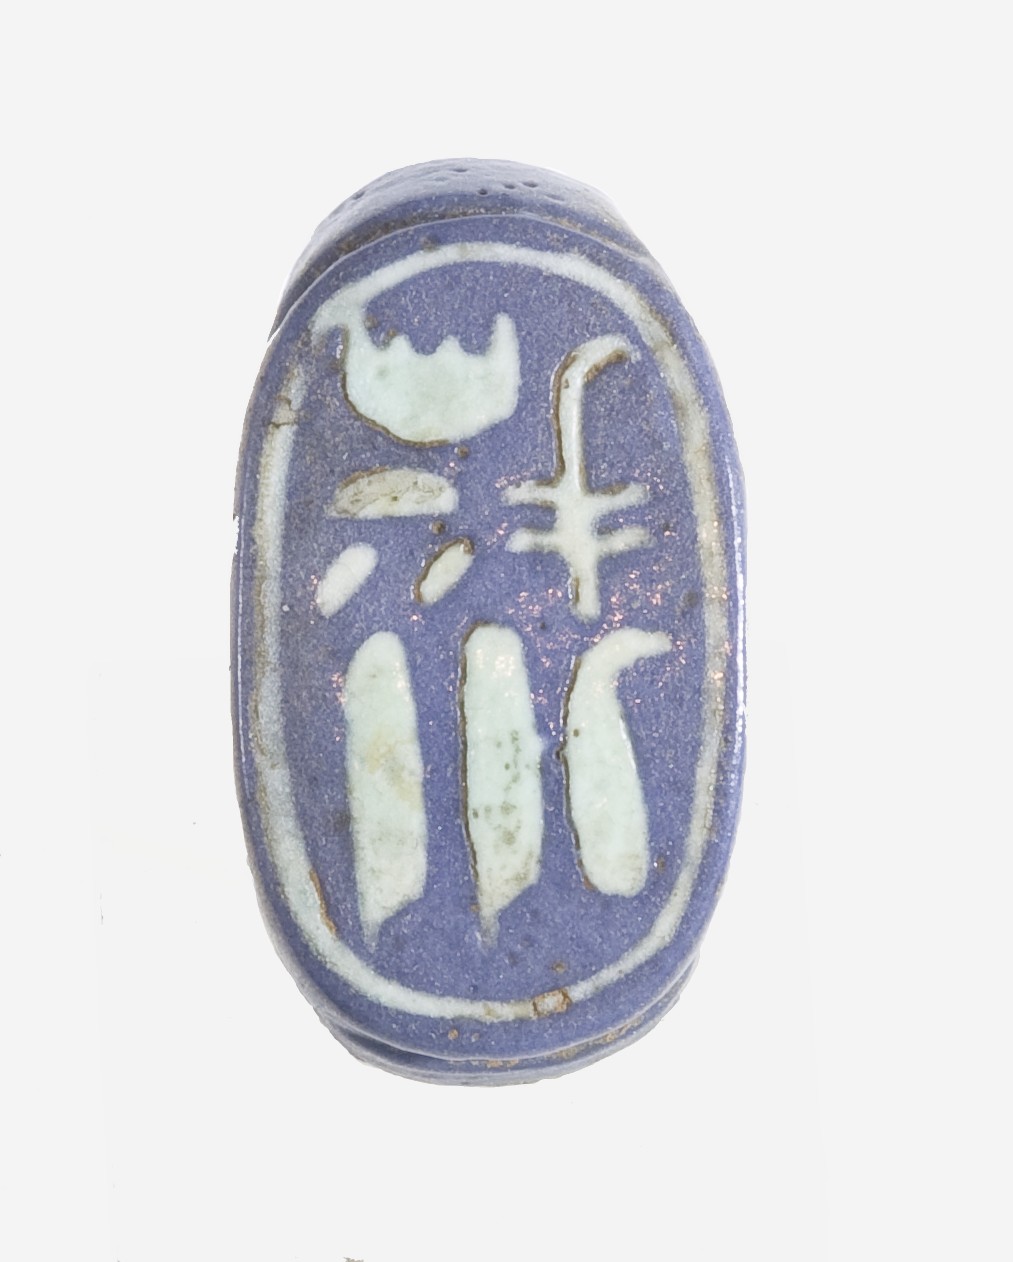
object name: ring, tiye, king's wife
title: Ring Inscribed for Queen Tiye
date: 1390-1352 BCE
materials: faience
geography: egypt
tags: hieroglyphs